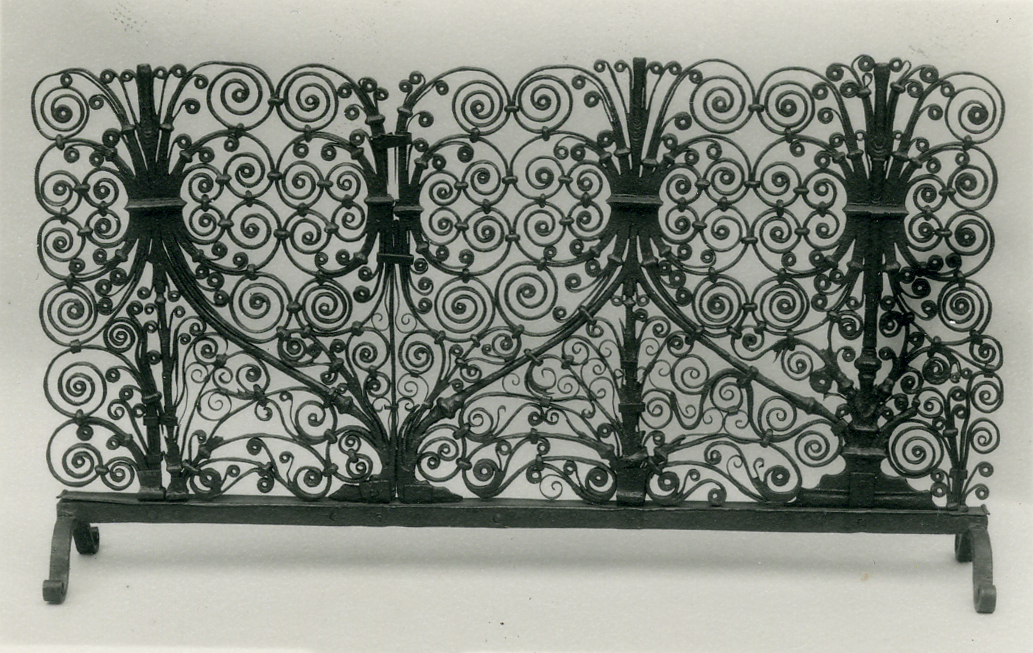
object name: gate fragment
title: Gate Fragments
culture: french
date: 1201-1400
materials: iron